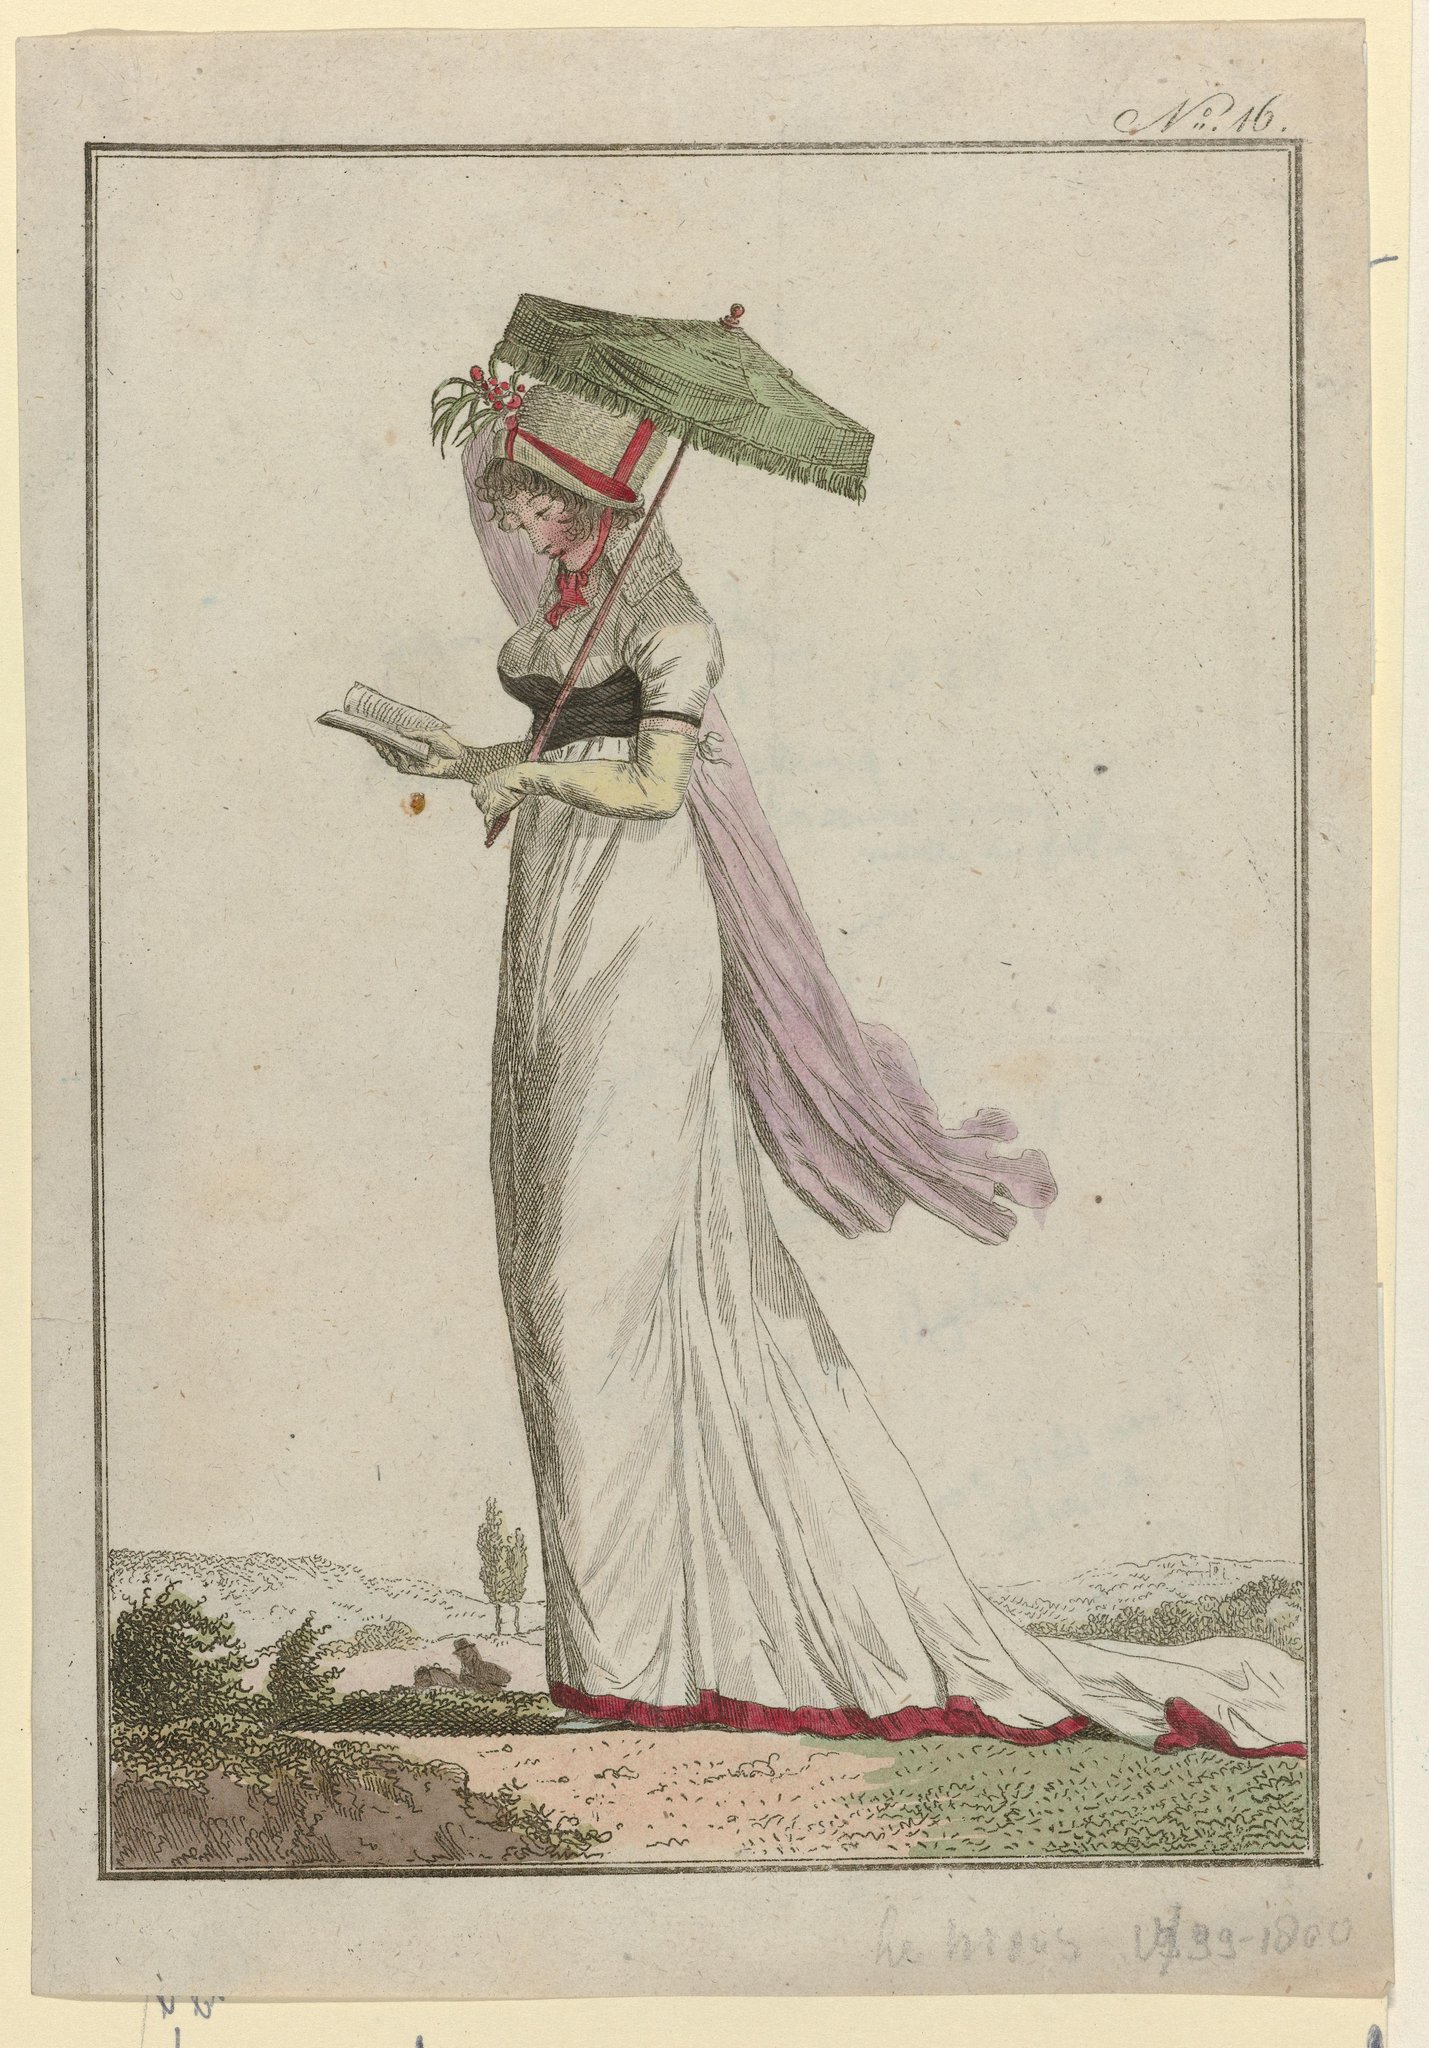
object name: fashion print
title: Le Mois, 1799-1800, No. 16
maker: philibert-louis debucourt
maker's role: painter, print maker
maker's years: 1755-1832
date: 1799-1800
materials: paper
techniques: etching, hand coloring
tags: gloves, mittens (long gloves) (+ women's clothes), veil (+ women's clothes), head-gear (+ women's clothes), fashion plates, dress, gown (+ women's clothes), book - mm - book open, parasol, sunshade (+ women's clothes)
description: Vrouw gekleed in een japon met opstaande kraag, korte mouwen en sleep. Accessoires: parasol afgezet met franjes, hoed met sluier, lange handschoenen. Geopend boek in de hand. Prent waarschijnlijk uit het modetijdschrift Le Mois, Journal historique, litteraire et critique, avec figures, par un Société de Gens de lettres, Parijs, april 1799 - juli 1800. De prent is waarschijnlijk een kopie naar No. 32 uit het modetijdschrift Modes et manières du Jour, 1798-1808.